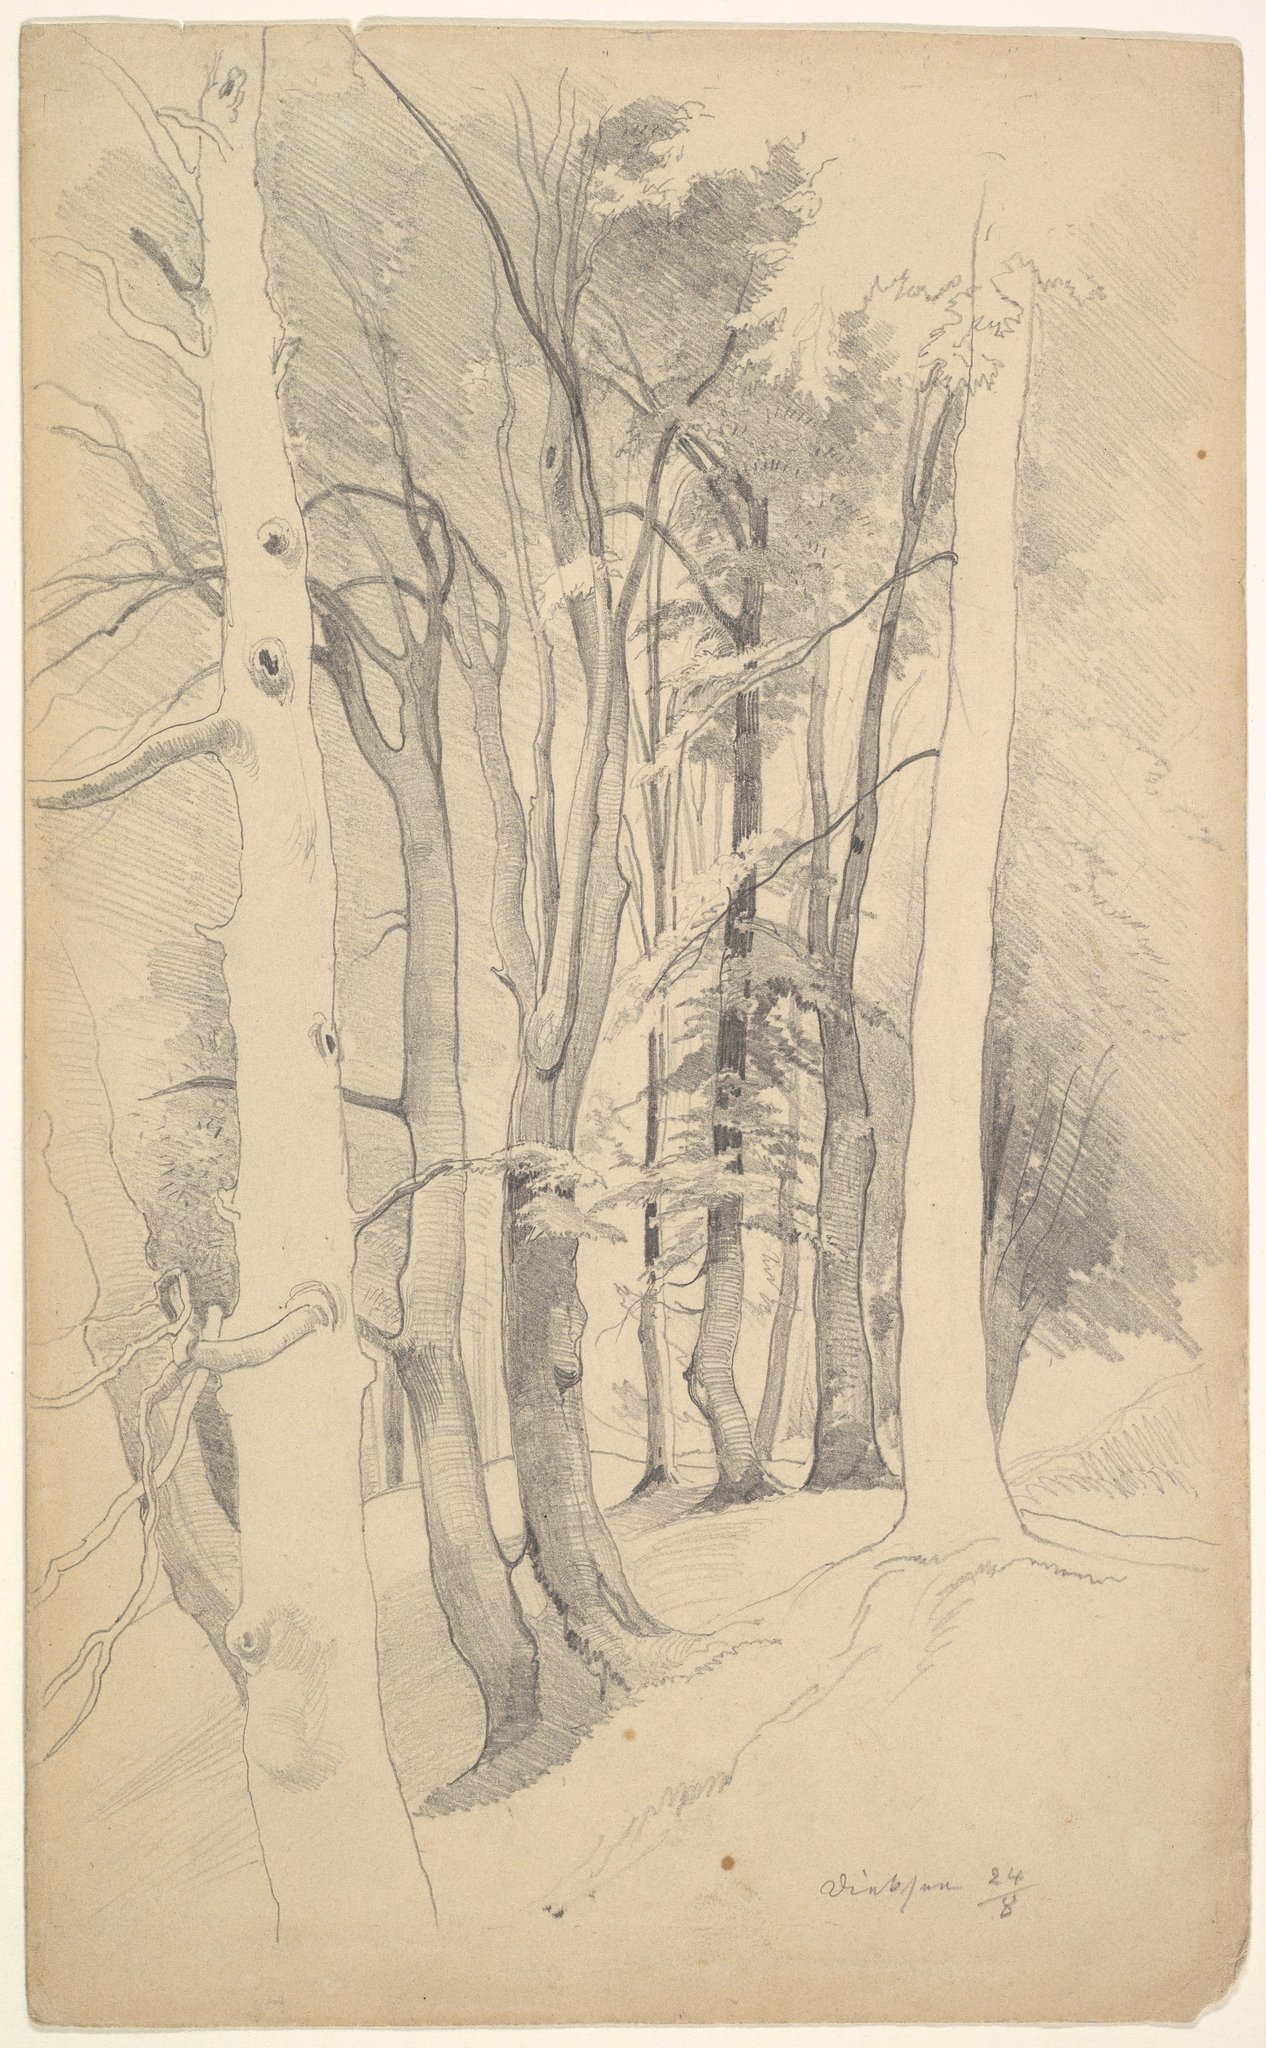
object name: drawing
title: Trees near Diessen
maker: carl maria nicolaus hummel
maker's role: artist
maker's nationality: german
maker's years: 1821-1907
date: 1834-1933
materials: graphite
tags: trees